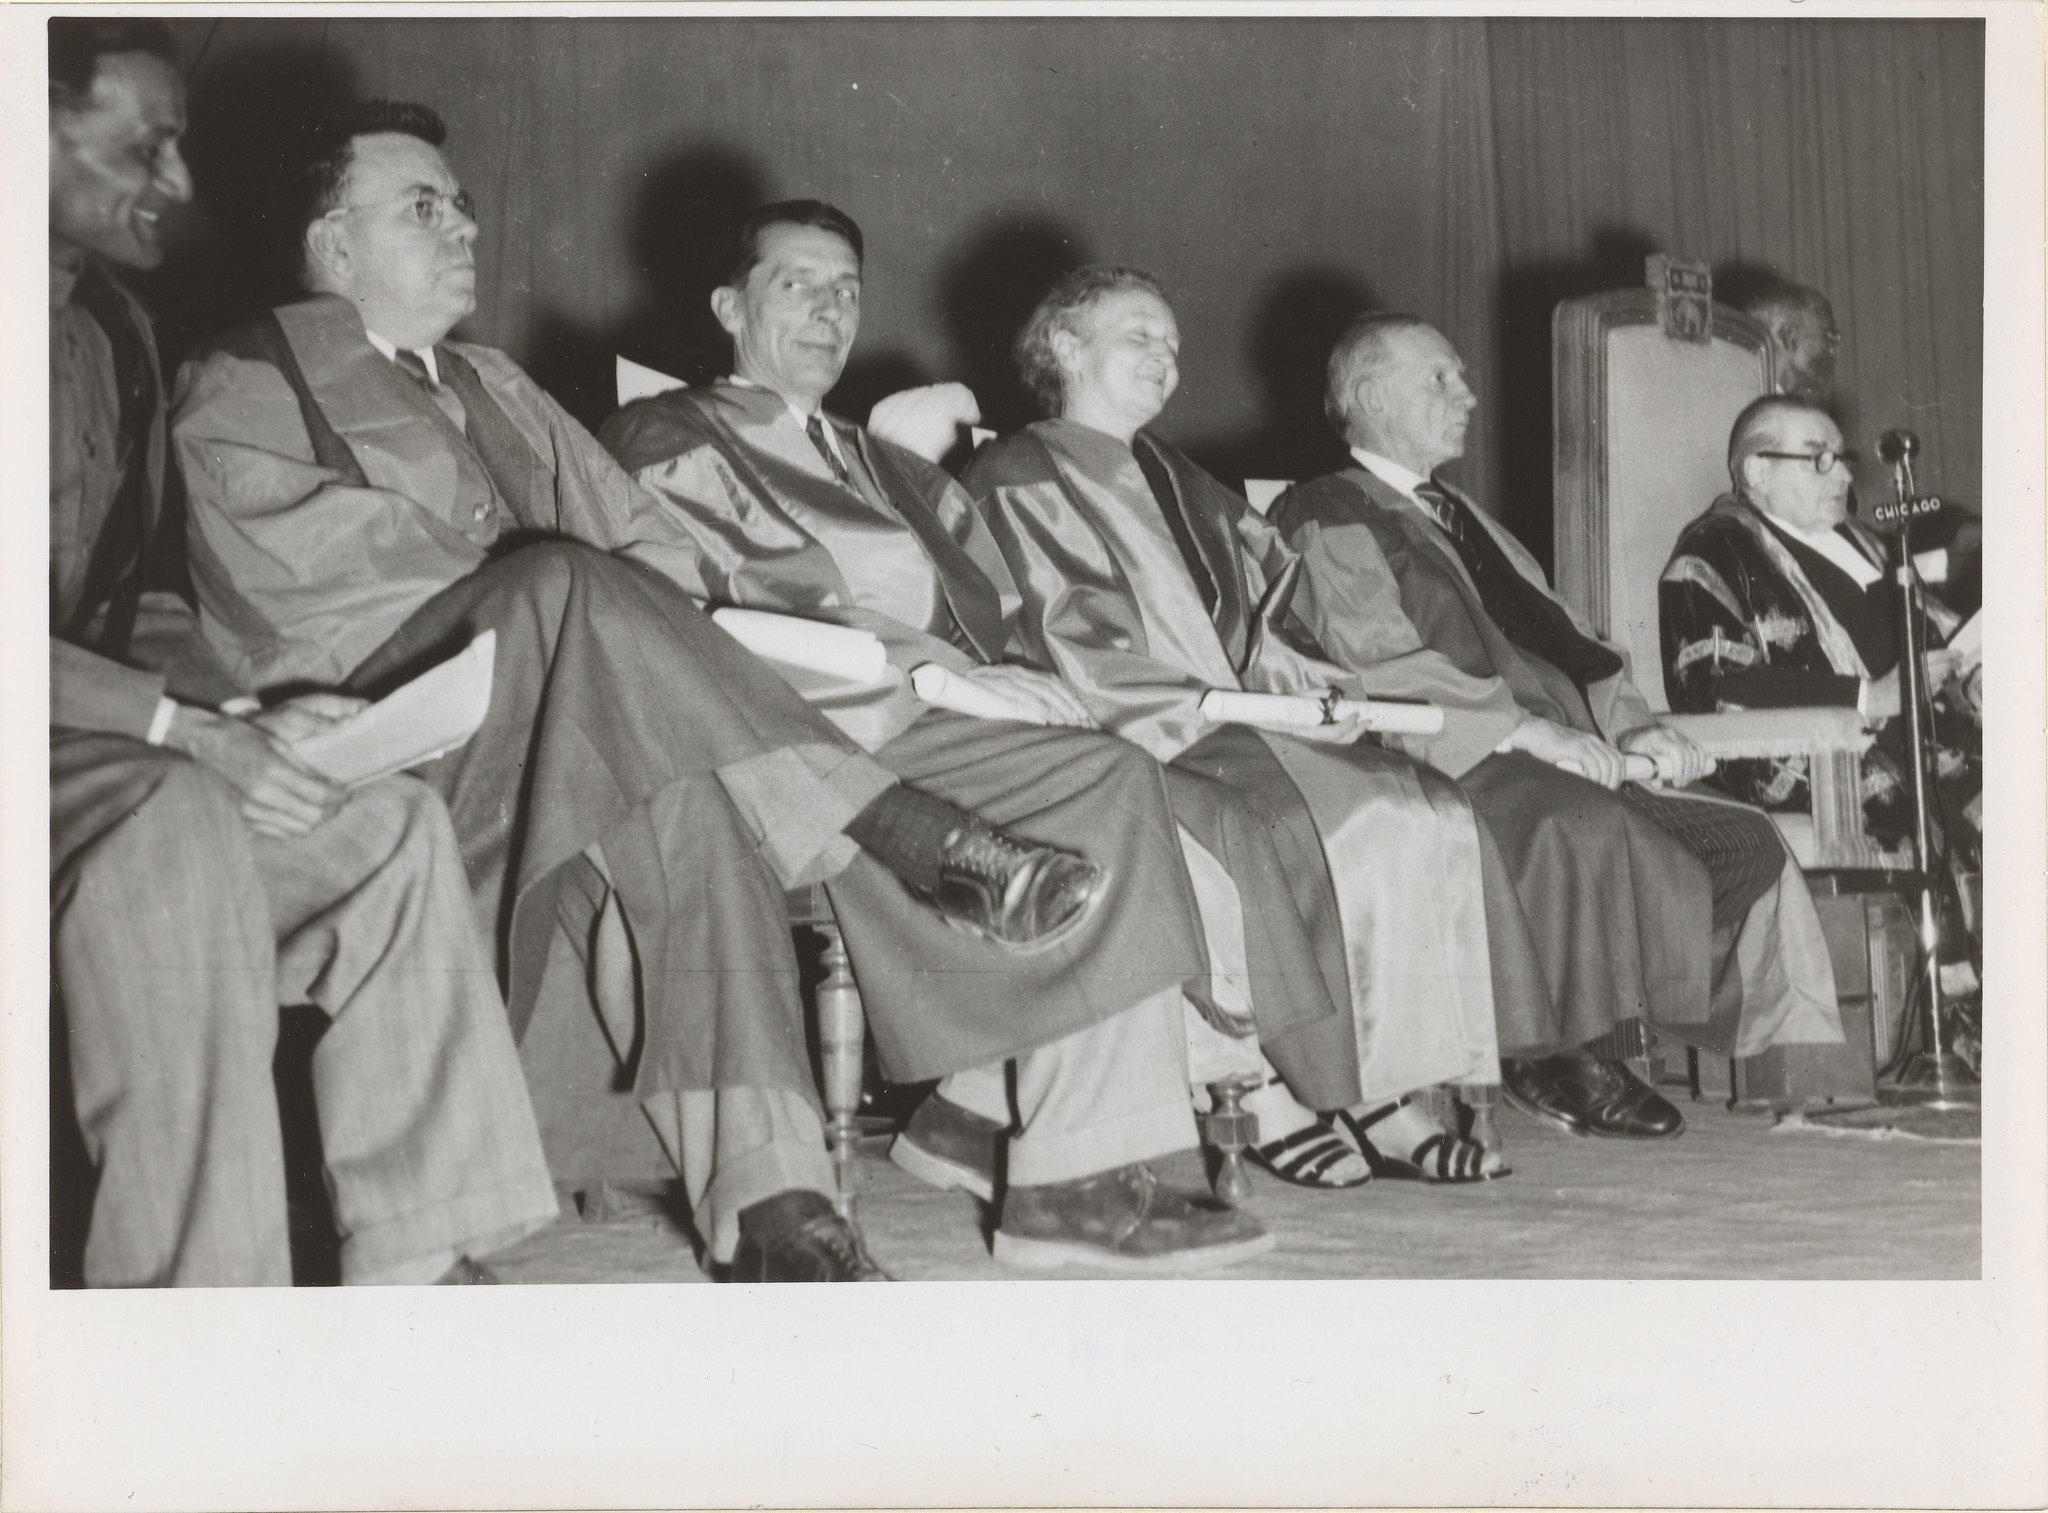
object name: photograph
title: M. Gwyer, Mme Curie, Prof. Joliot, Sir. R. Robertson,Delhi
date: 1950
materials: photographic support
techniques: gelatin silver print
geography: new york city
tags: frédéric joliot-curie, irène joliot-curie, scheikundige, robert robinson, wetenschapper, edward condon, delhi